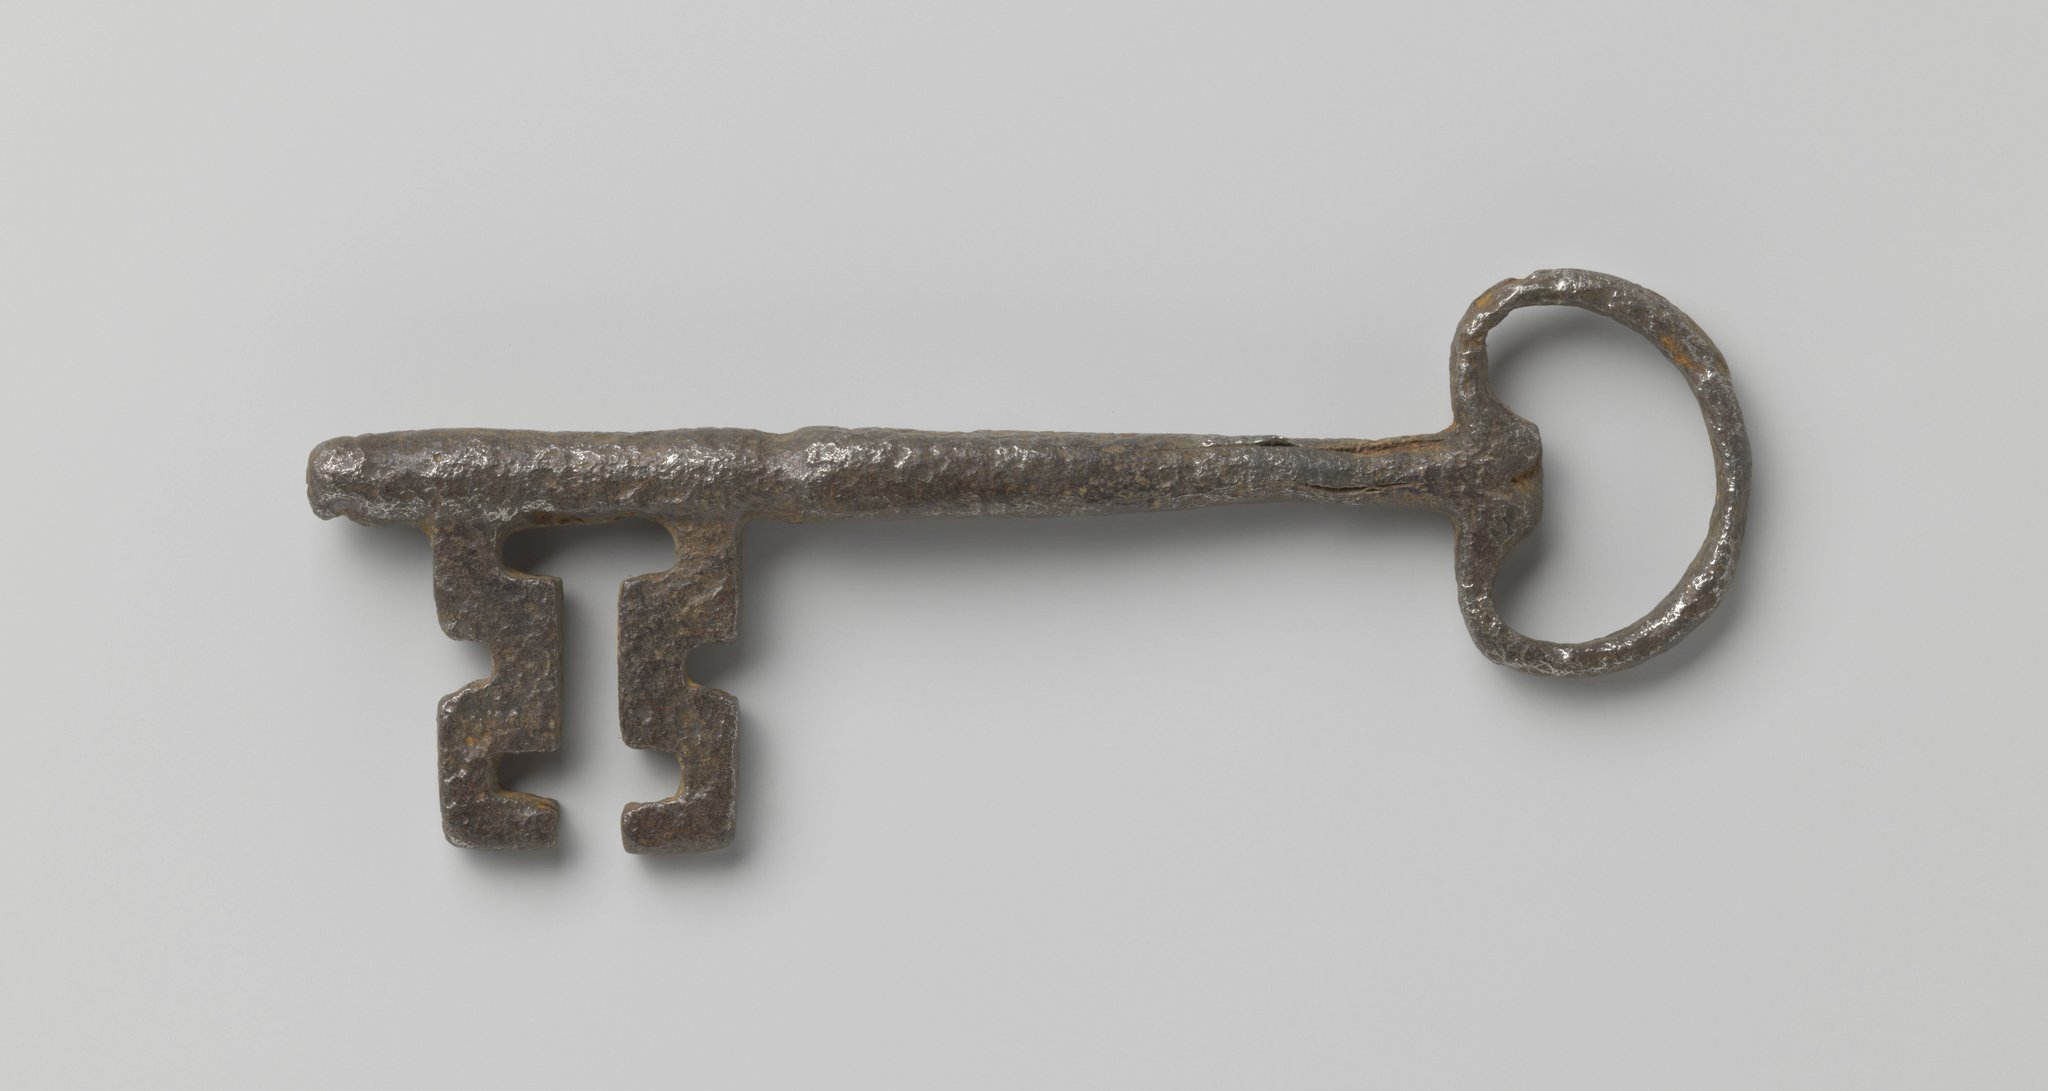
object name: key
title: Sleutel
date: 1600-1699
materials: iron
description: Sleutel met boonvormig oog en tweeledigen baard. De vierzijdige schacht die zich naar onderen iets verbreedt, gaat bij de baard in een dunner gedeelte over.